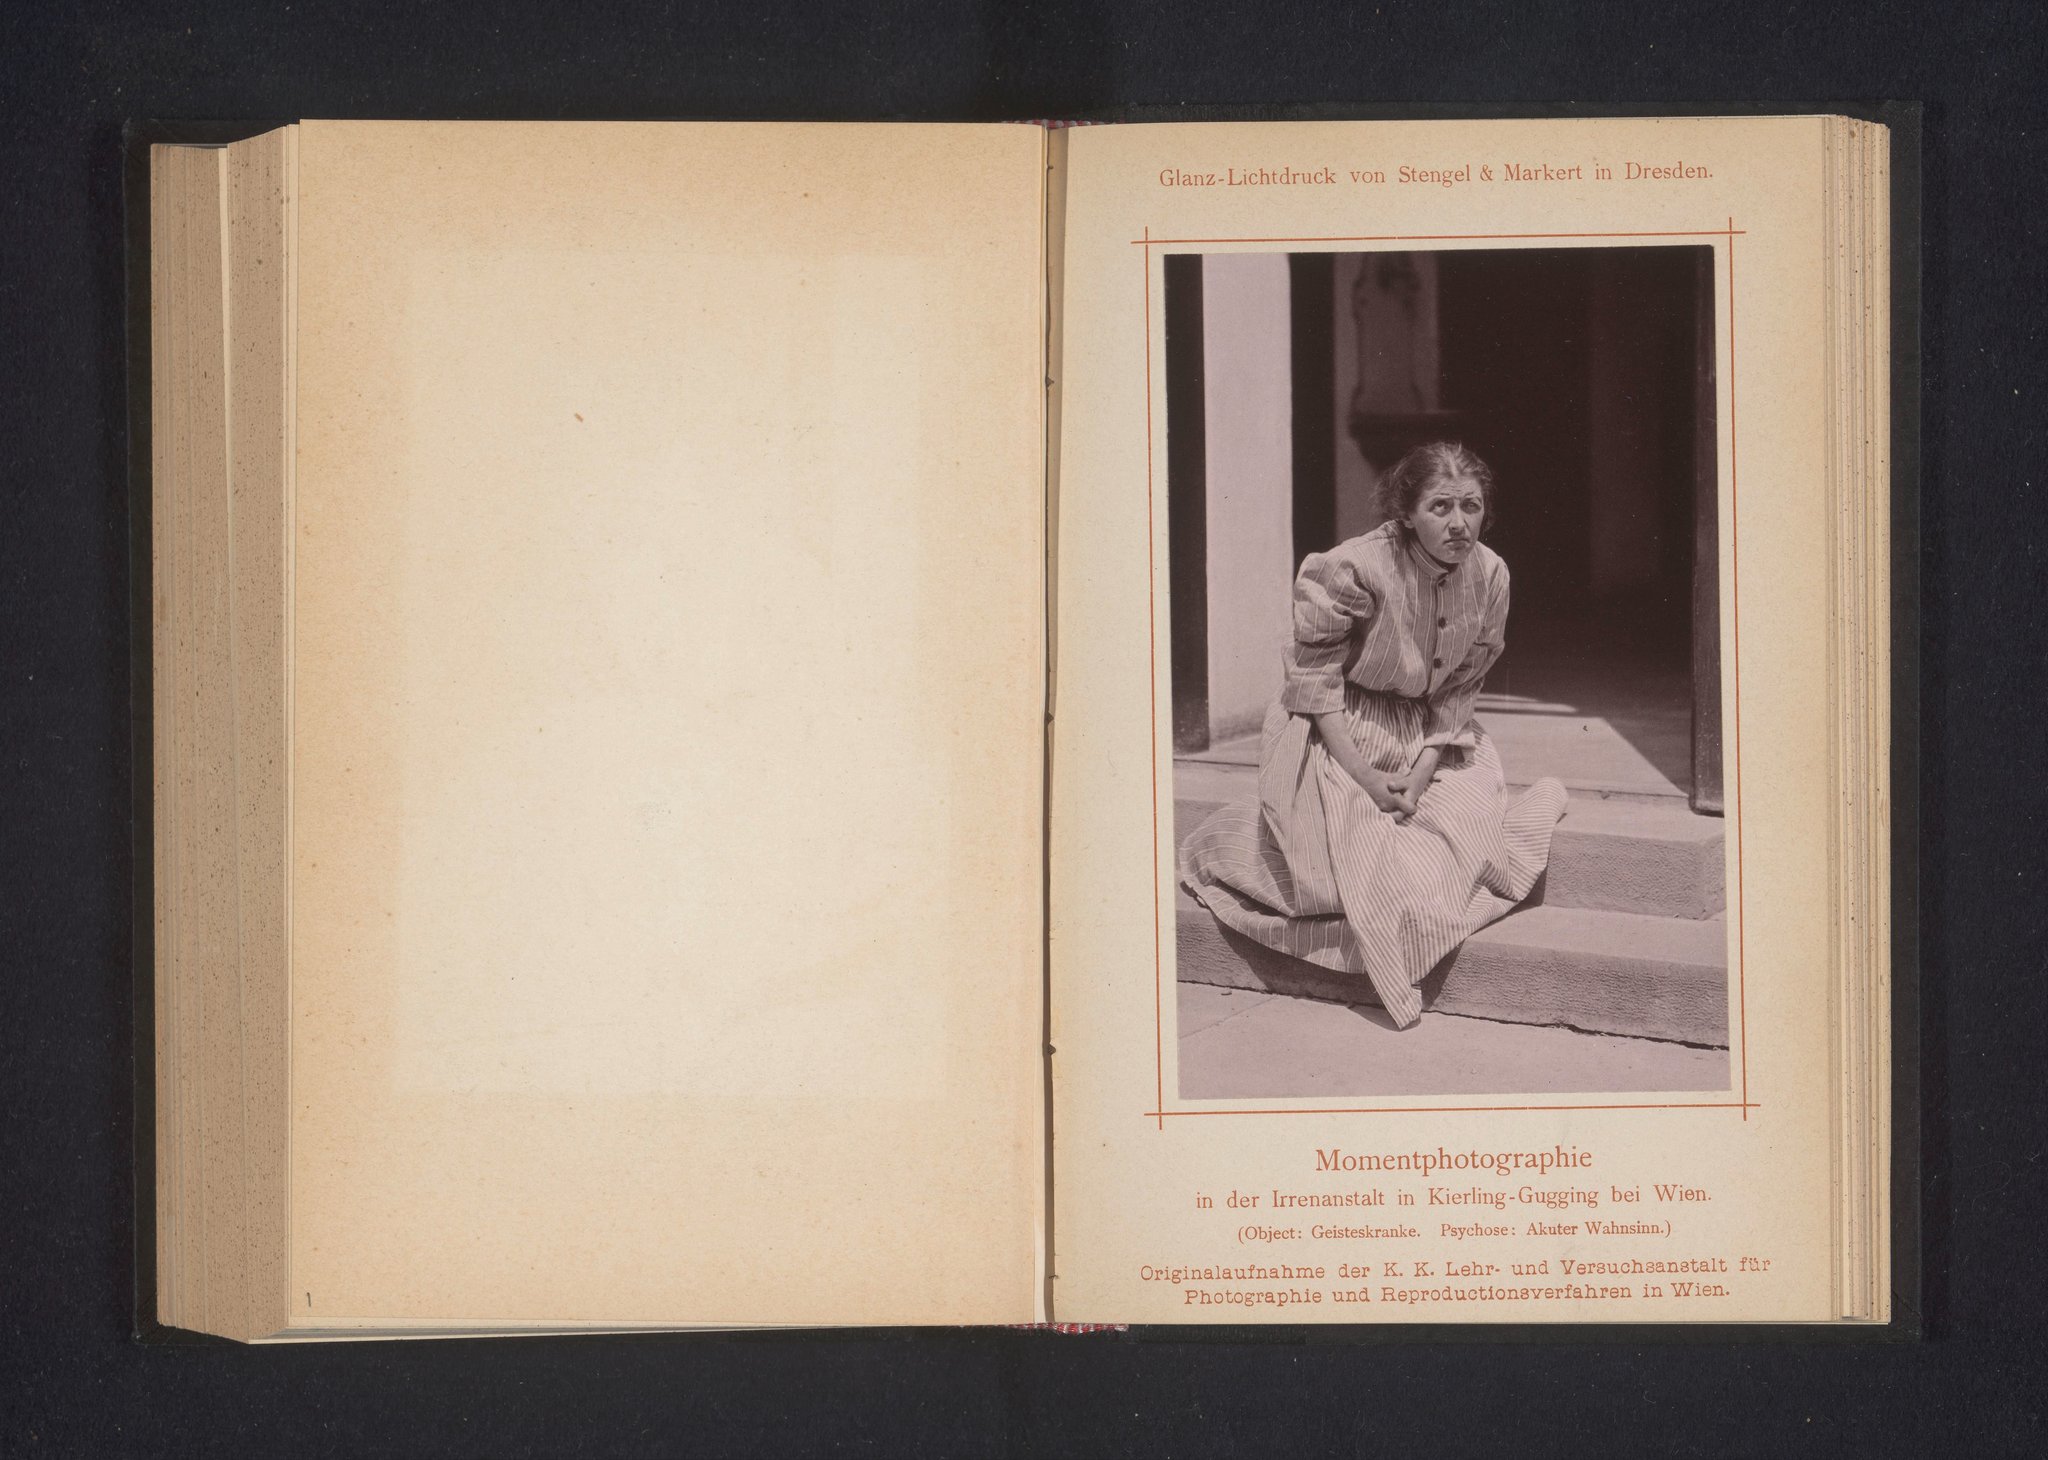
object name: photomechanical print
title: Portret van een onbekende vrouw in een psychiatrische instelling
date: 1885-1890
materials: paper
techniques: photograph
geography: klosterneuburg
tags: historical persons - bb - woman, diseases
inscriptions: inscription: ‘Momentphotographie/ in der Irrenanstalt in Kierling-Gugging bei Wien./ (Object: Geisteskranke. Psychose: Akuter Wahnsinn.)’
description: Prent op vijfde ongenummerde pagina na pagina 400.